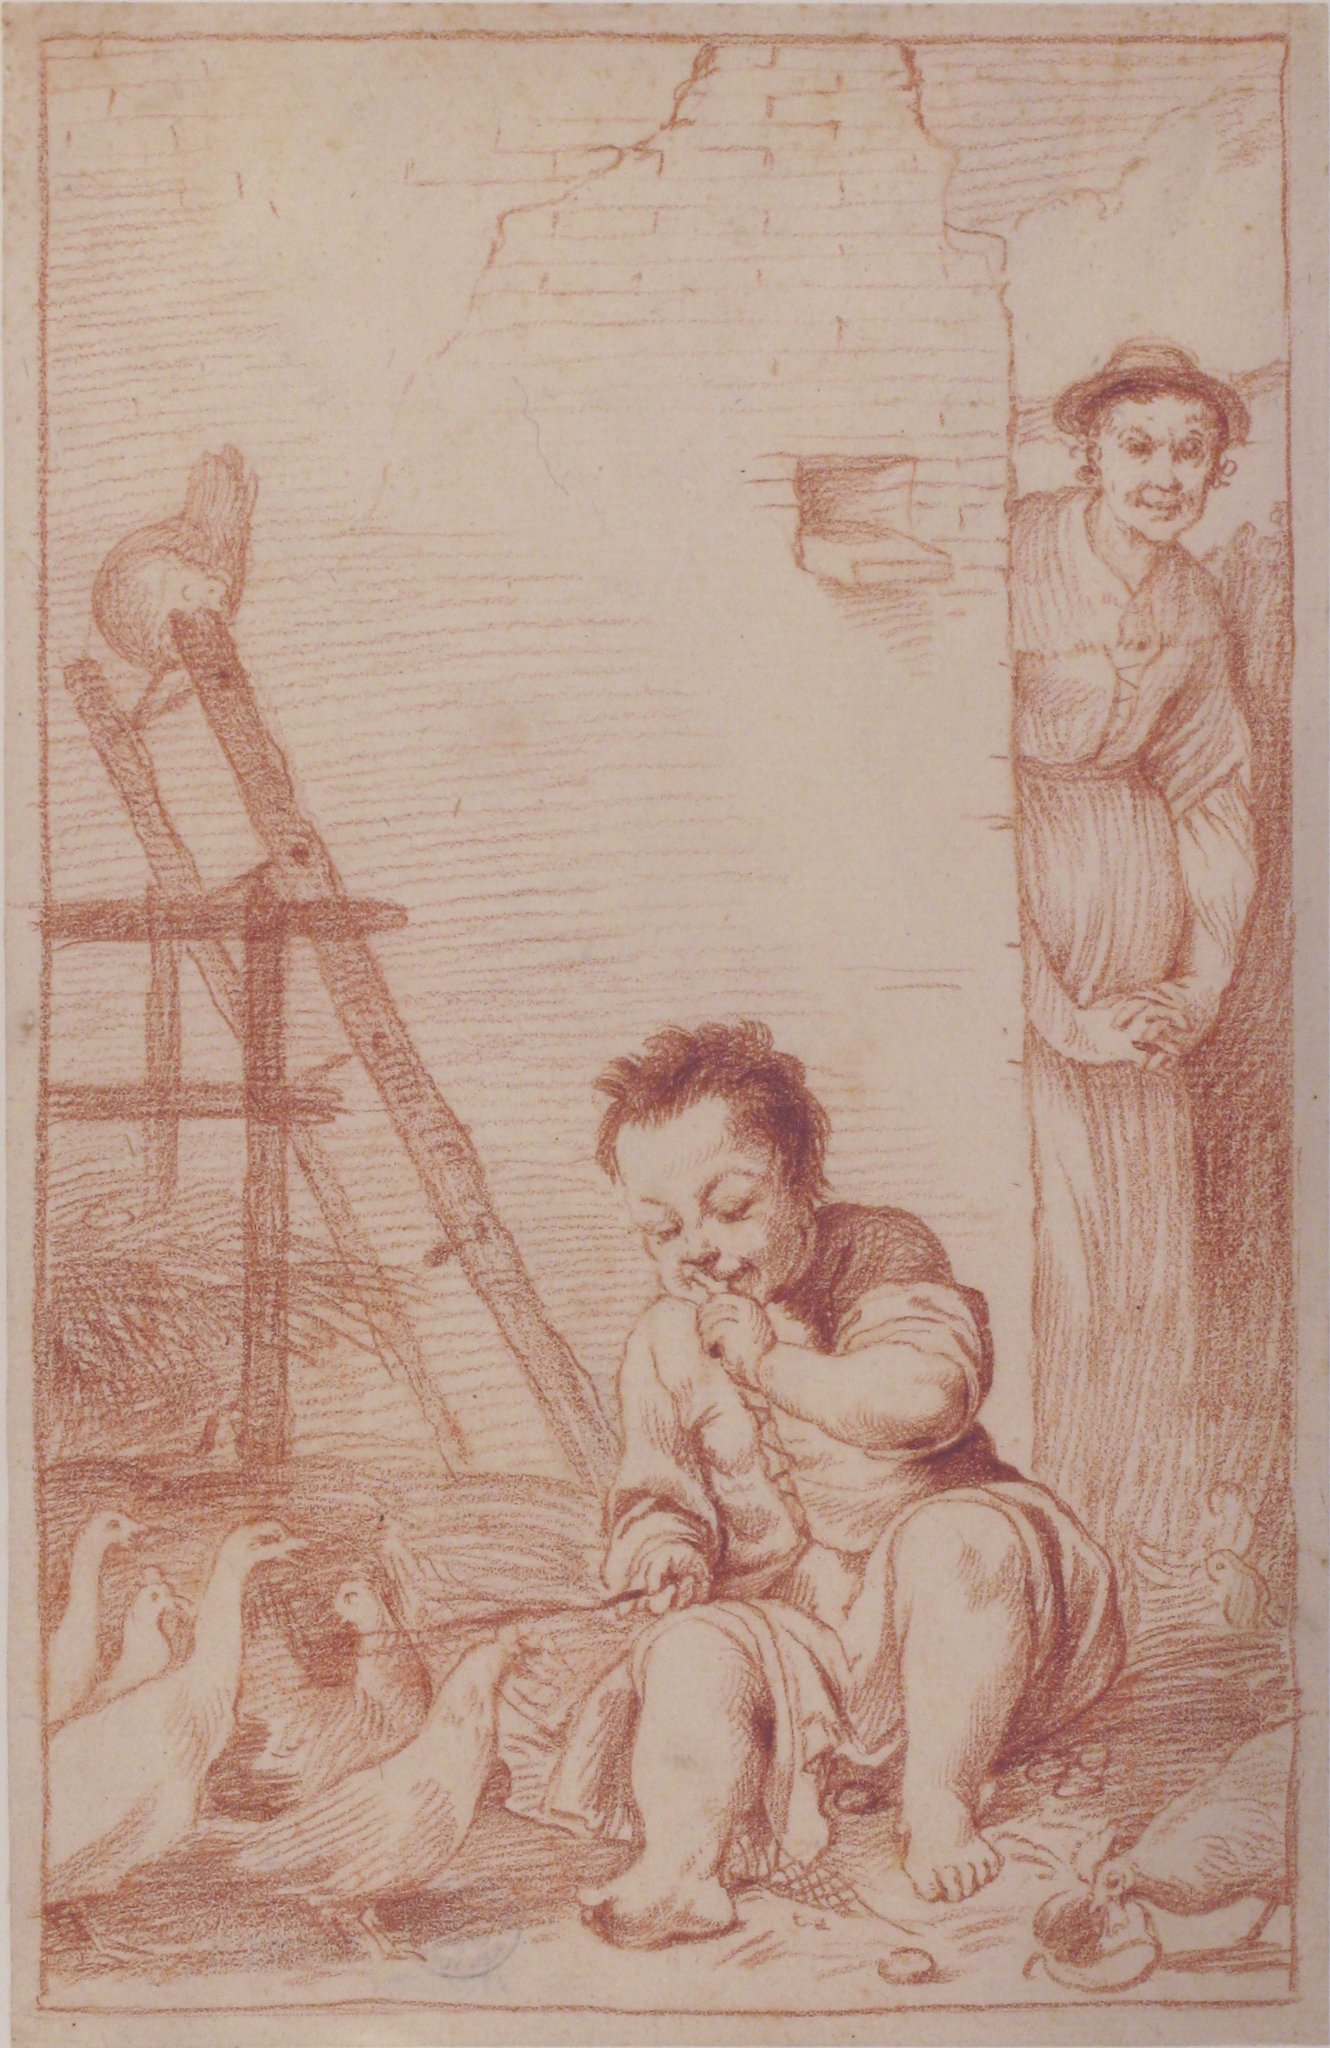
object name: drawing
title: Marcolfa Discovers BertoldinoTrying to Hatch Eggs (recto); Sketch of Bertoldino (verso)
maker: giuseppe maria crespi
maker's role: artist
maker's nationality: italian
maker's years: 1665-1747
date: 1709-1710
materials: chalk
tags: birds,children,women